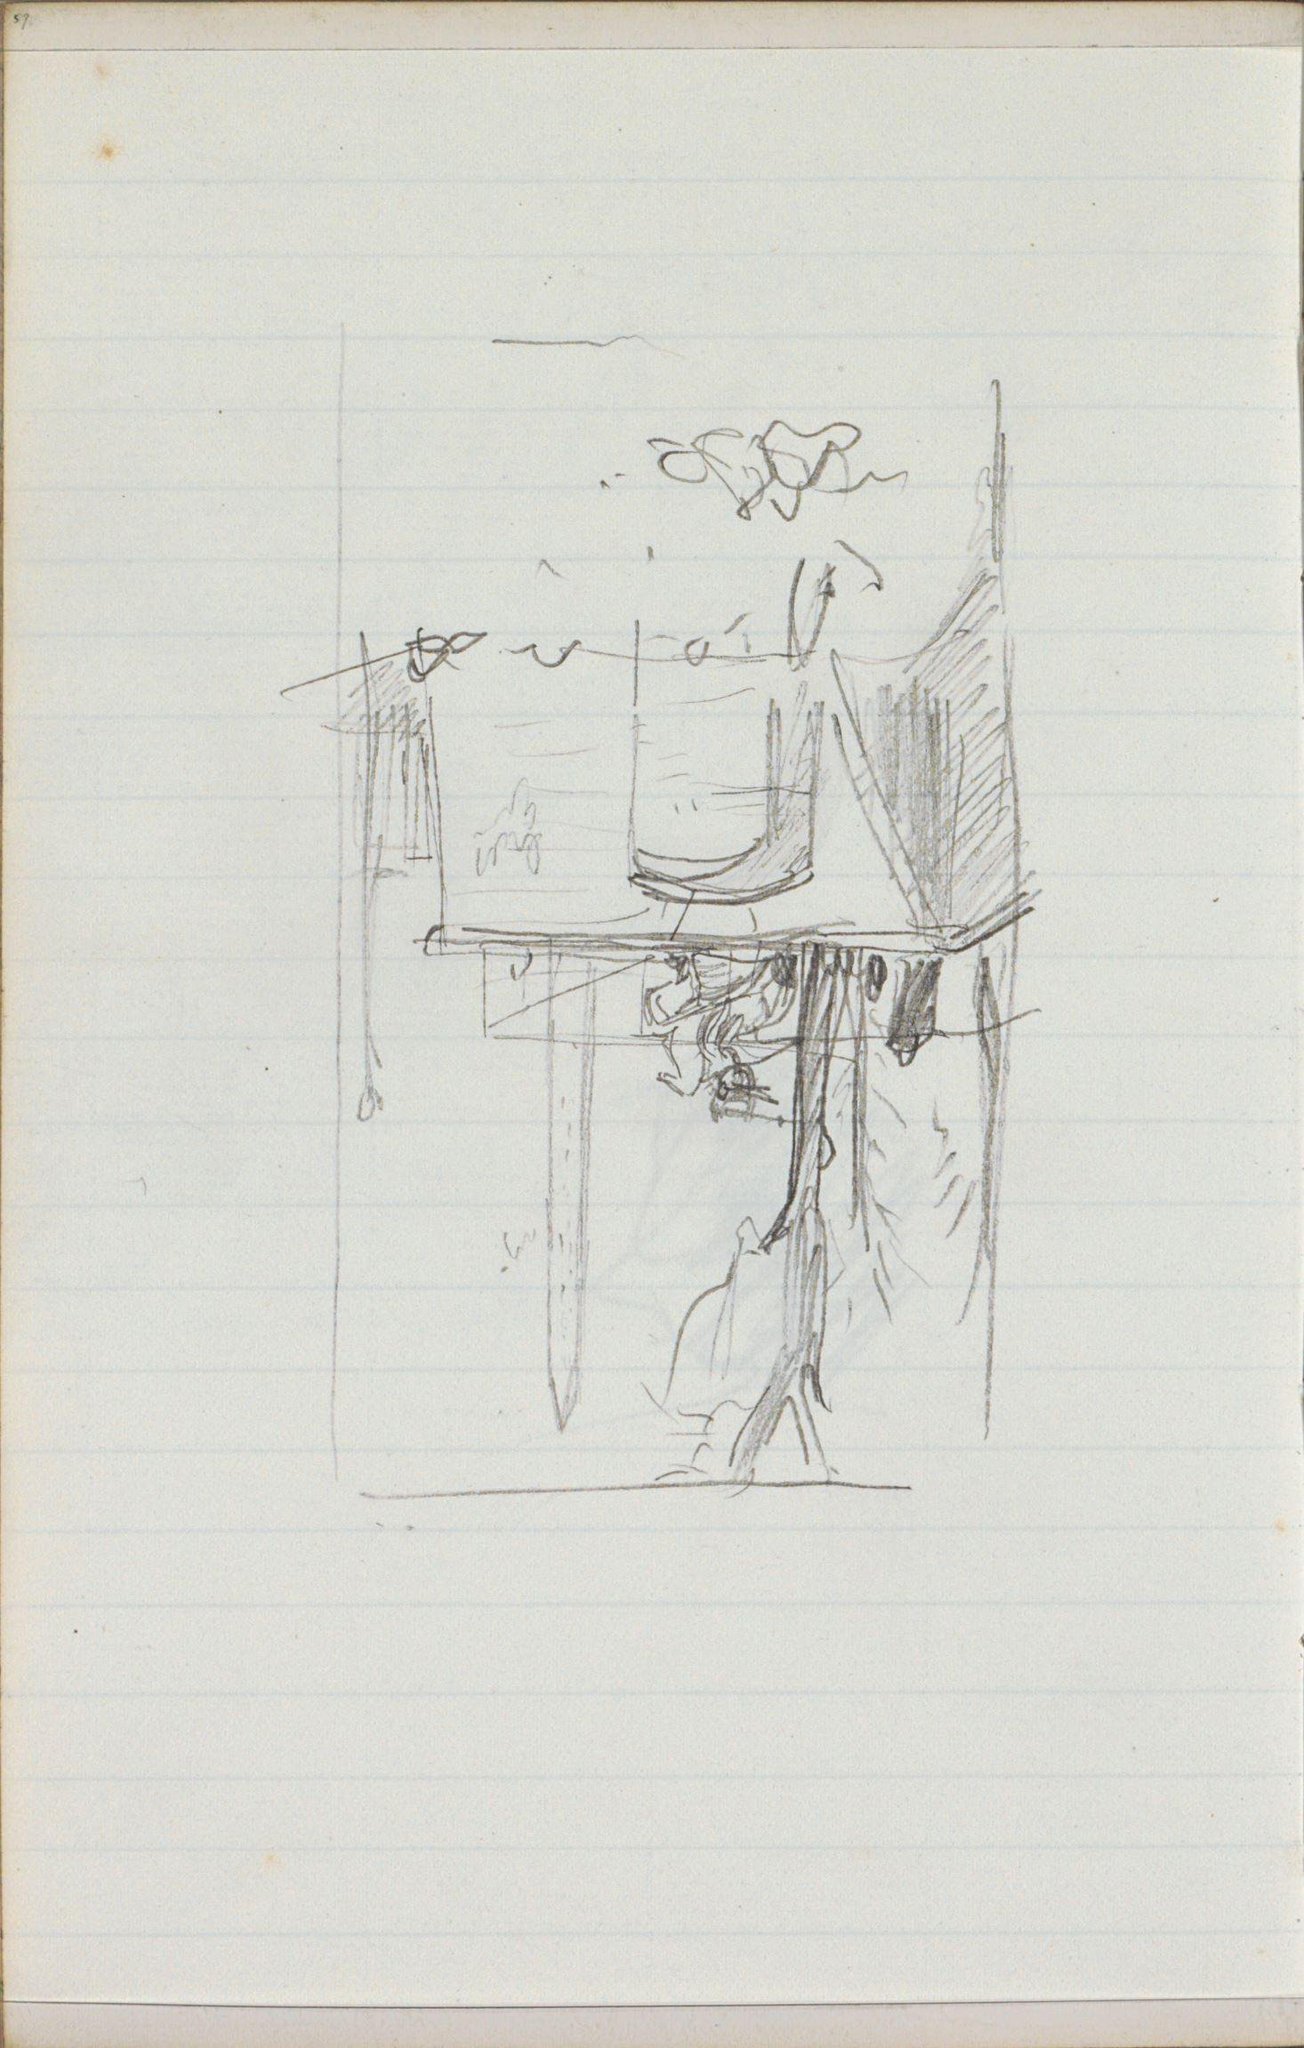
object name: sketchbook leaf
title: Beeld van La Renommée (Fama) met trompet op het gevleugelde paard Pegasus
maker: marius bauer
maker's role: draughtsman, print maker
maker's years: 1867-1932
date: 1877-1932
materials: pencil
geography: paris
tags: pegasus, the winged horse, obelisk, needle, monument, statue, fame; 'fama', 'fama buona', 'fama chiara' (ripa)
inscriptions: kleurnotitie, handgeschreven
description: Het beeld stelt la Renommée voor, oftewel de roem van de koning, gezeten op het gevleugelde paard Pegasus. Het beeld werd gemaakt door Antoine Coysevox in 1702.